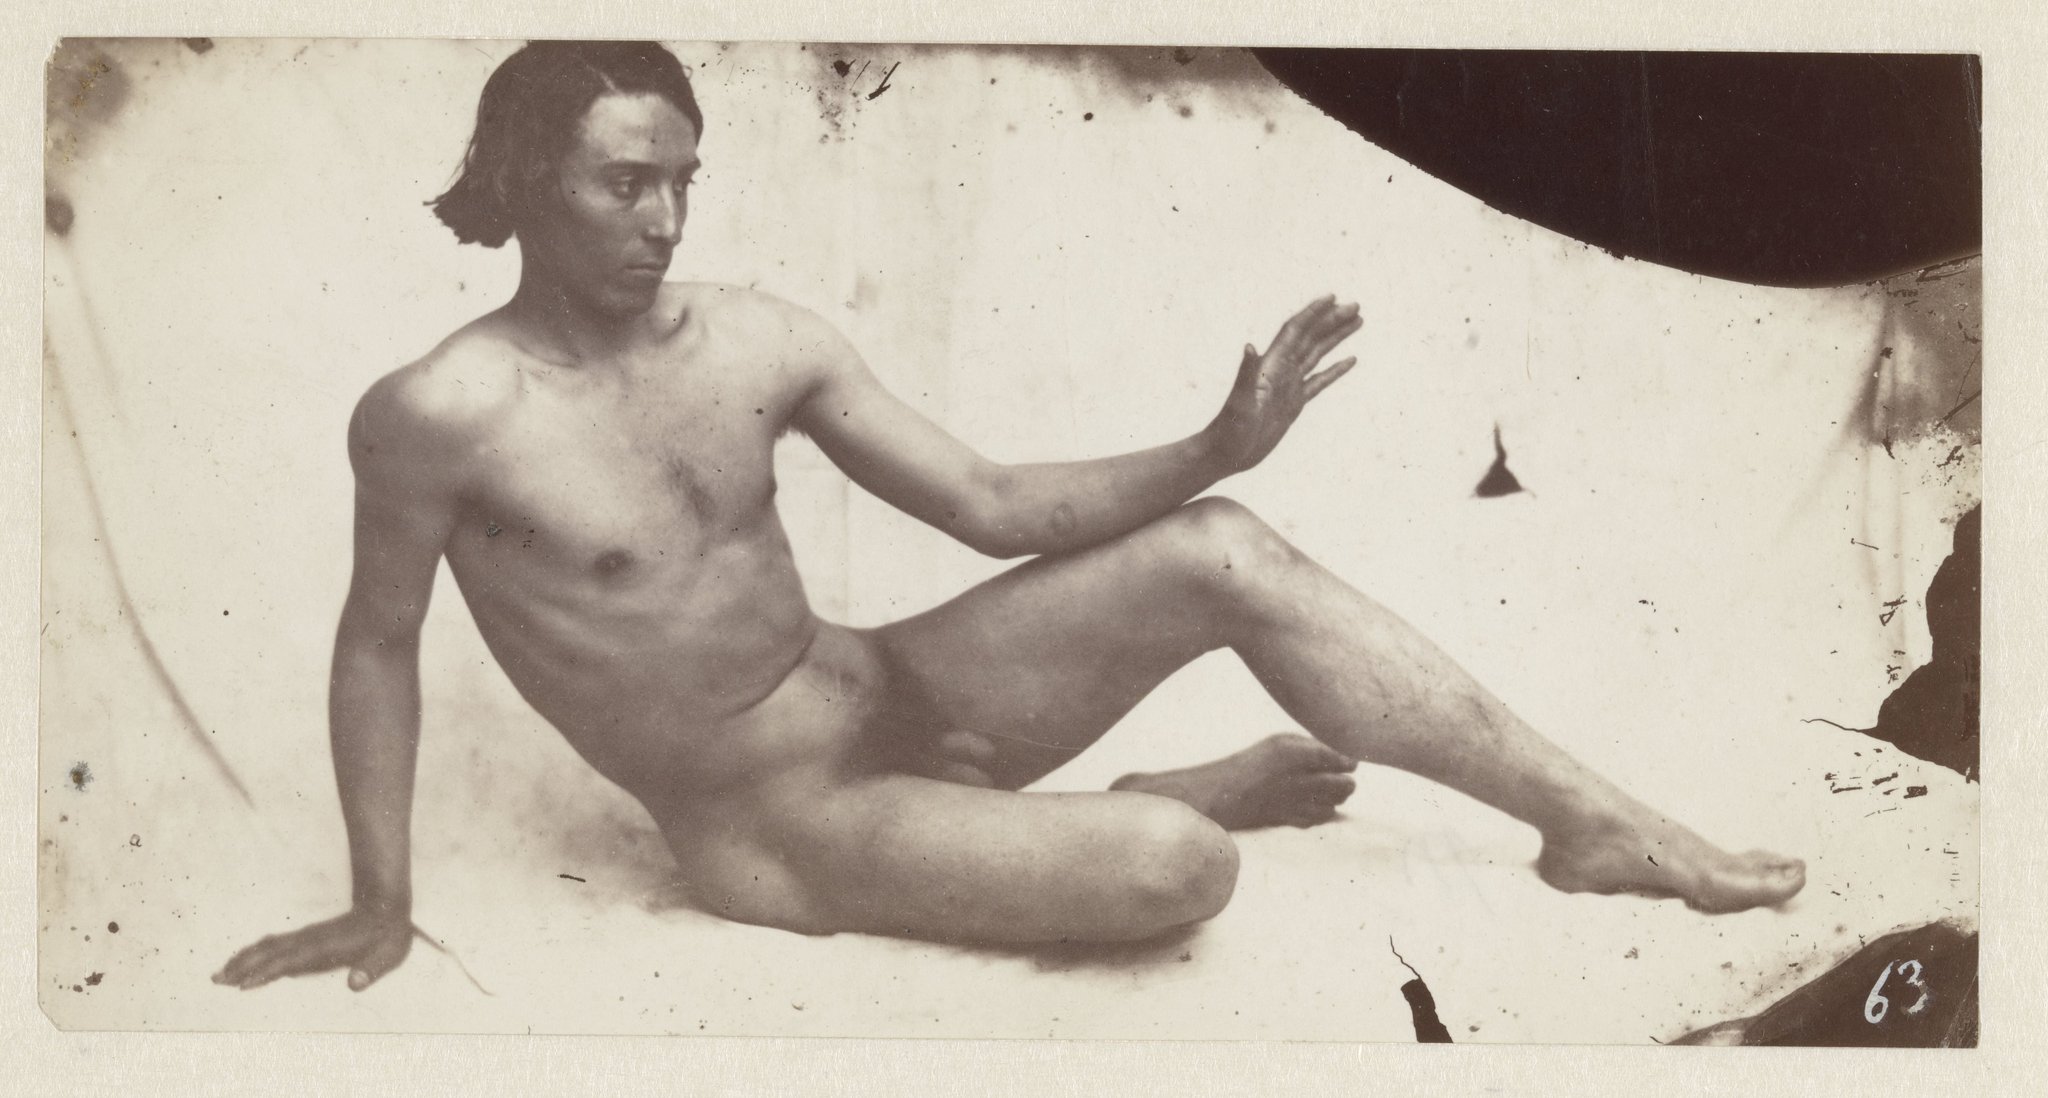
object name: photograph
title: Male Nude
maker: Anonymous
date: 1880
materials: paper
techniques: albumen print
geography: france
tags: human figure of ideal proportions, e.g. academic nude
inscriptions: number: ‘63 M [?]’, number: ‘63’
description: Pornographic photography was strictly prosecuted in the 19th century. One way of lending a photograph of a nude some standing, and thus make it acceptable, was to have the model assume a pose derived from classical sculpture. The pose in this photograph seems loosely based on the famous Dying Gaul.